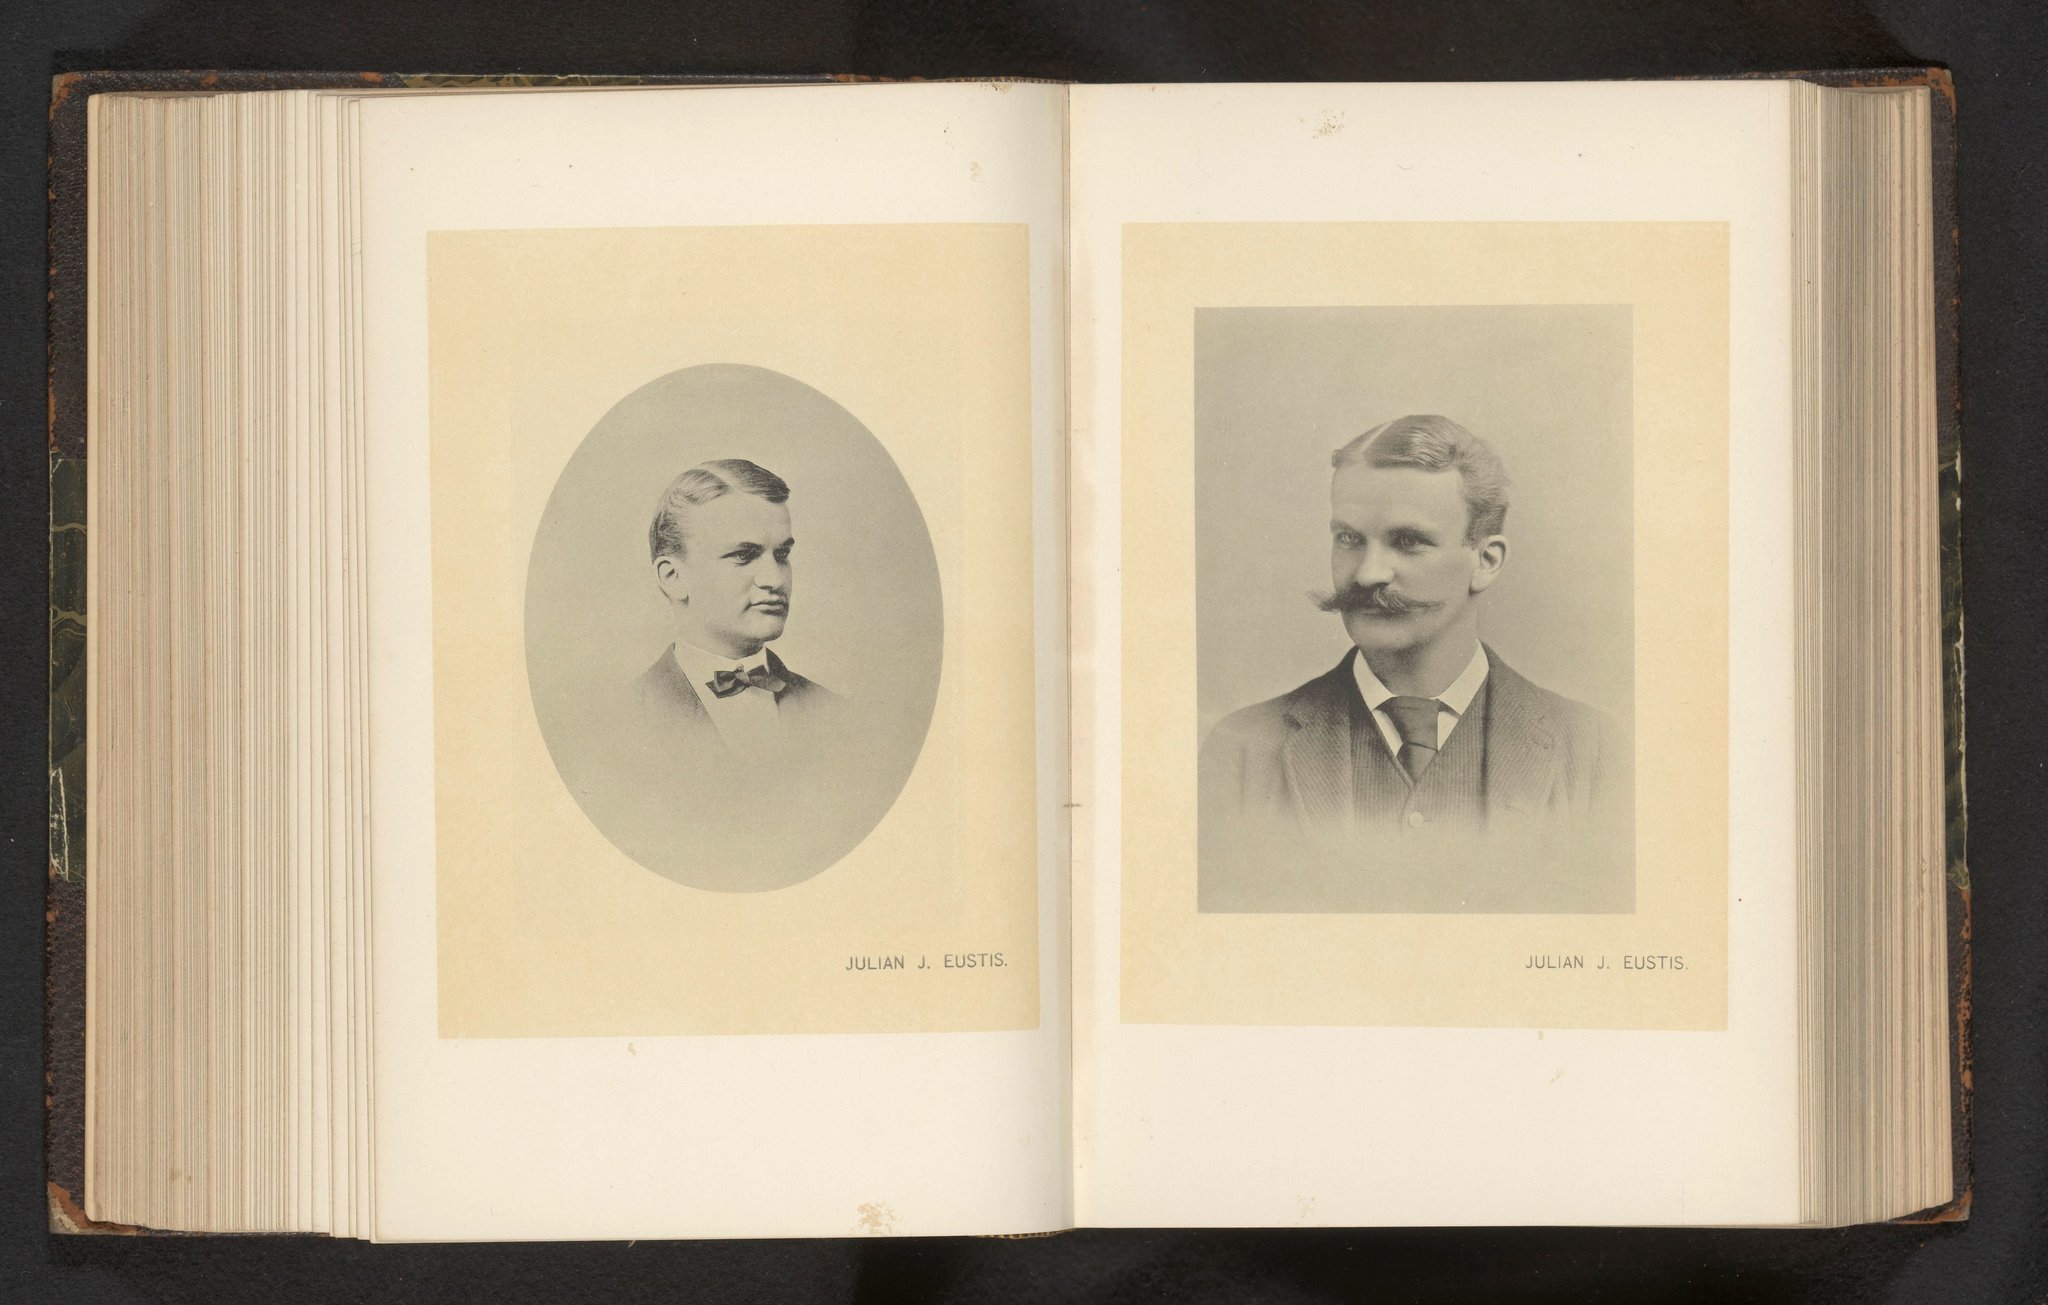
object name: photomechanical print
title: Julian J. Eustis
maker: Anonymous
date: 1889-1894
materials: paper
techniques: photoaquatint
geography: boston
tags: adult man